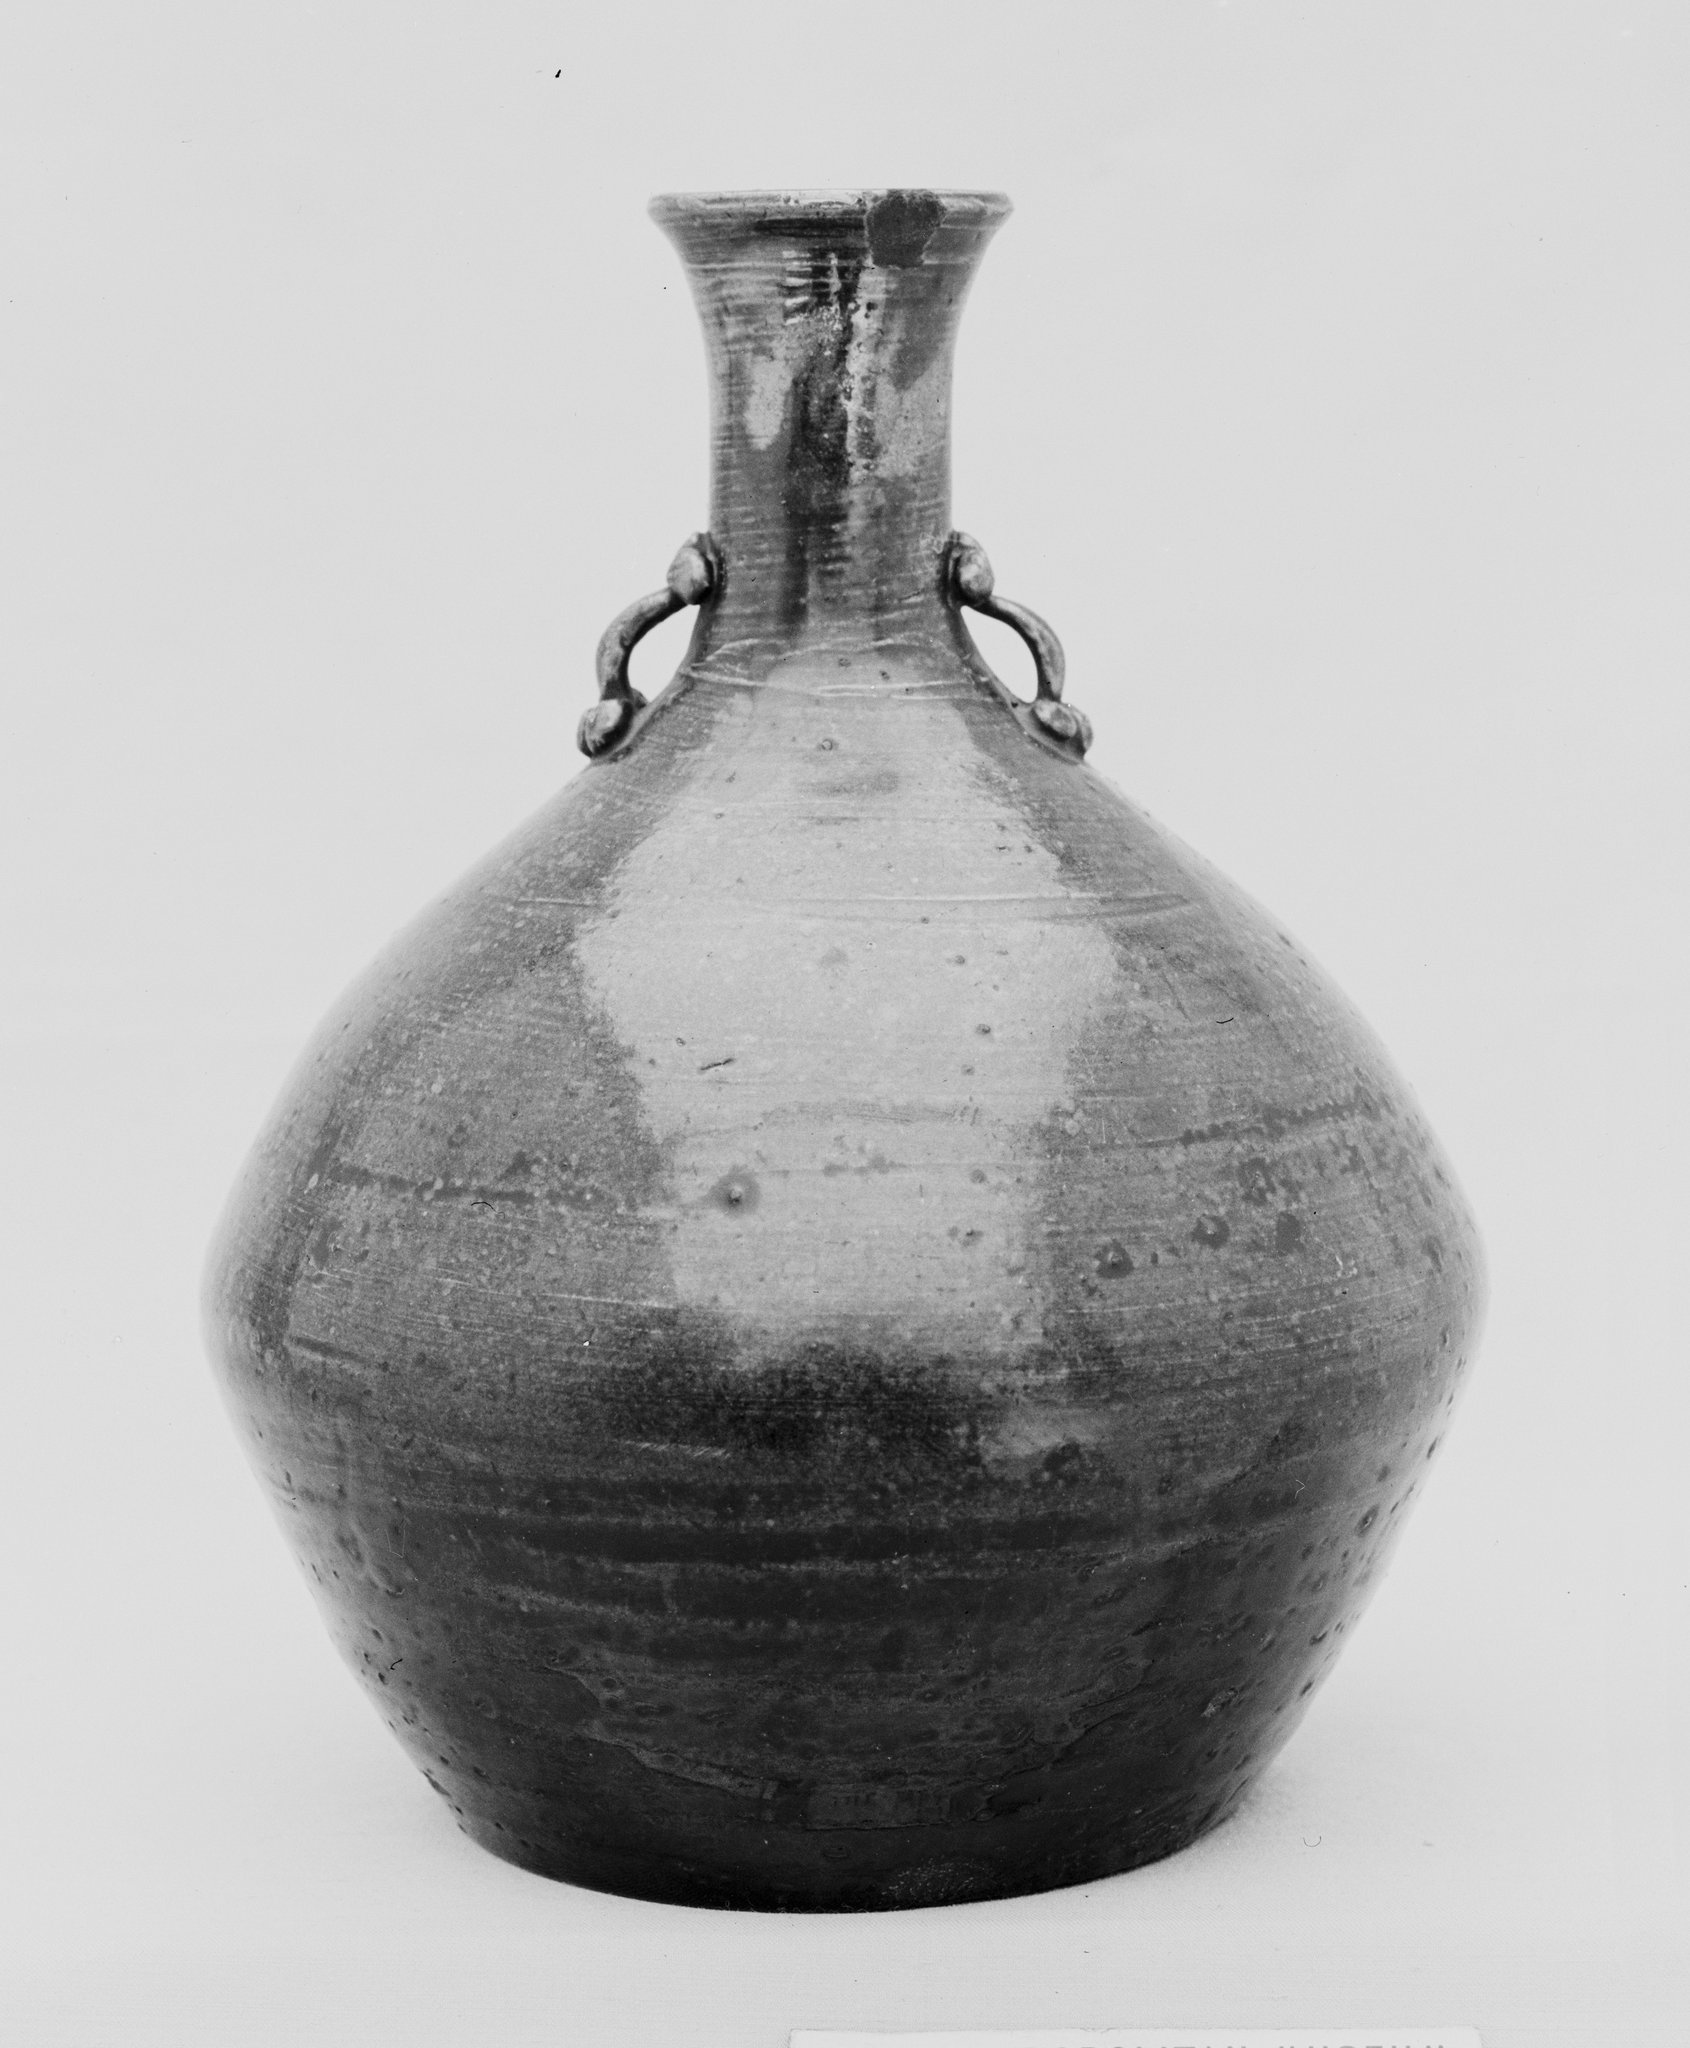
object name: bottle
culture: japanese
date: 1801-1900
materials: clay, glaze